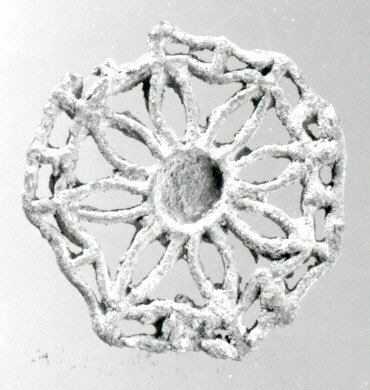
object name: stamp seal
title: Compartmented stamp seal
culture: bactria-margiana archaeological complex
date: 2333-1668 BCE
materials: copper alloy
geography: bactria-margiana